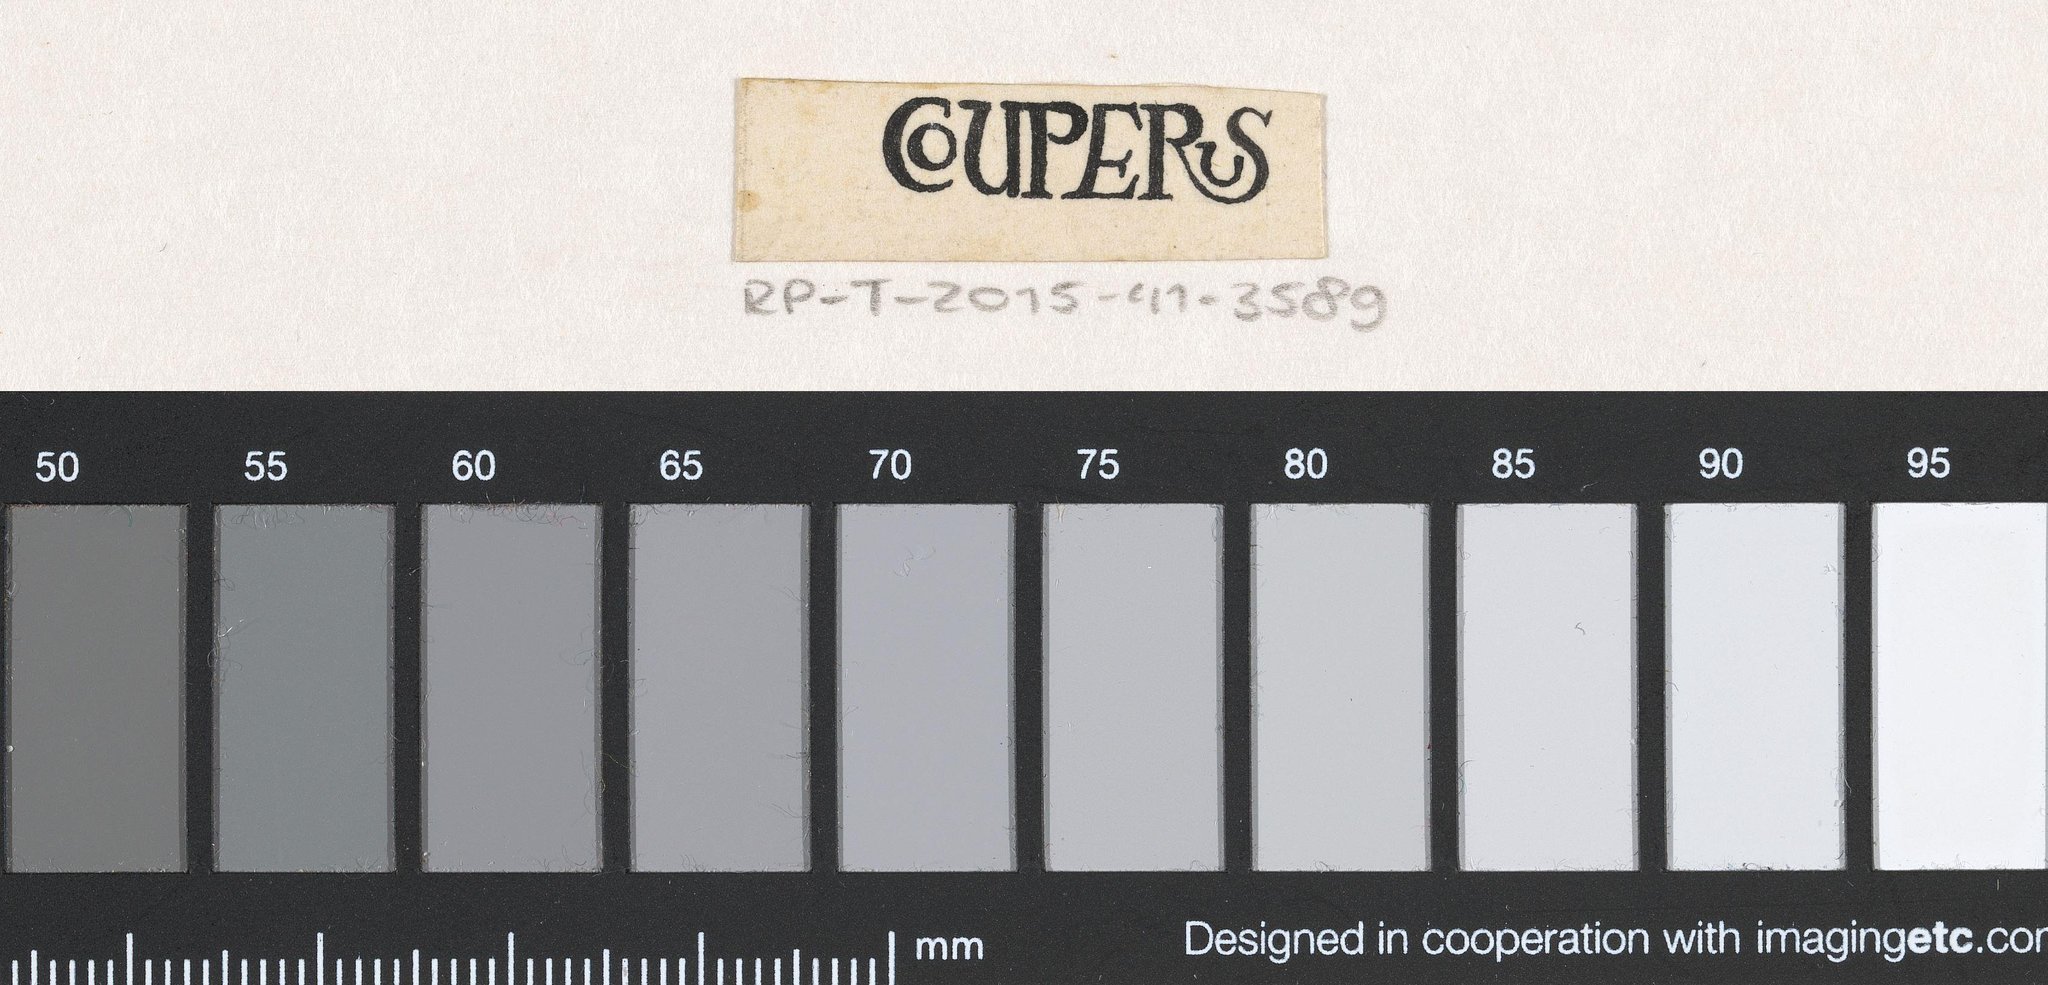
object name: drawing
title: Letterontwerp 'Couperus'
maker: Anonymous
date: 1890-1930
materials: ink, paper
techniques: pen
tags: fancy letters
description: Letterontwerp voor een boekband van één van de werken van Louis Couperus. De letter 'o' gaat op in de 'C' en de letter 'u' in de 'S'.